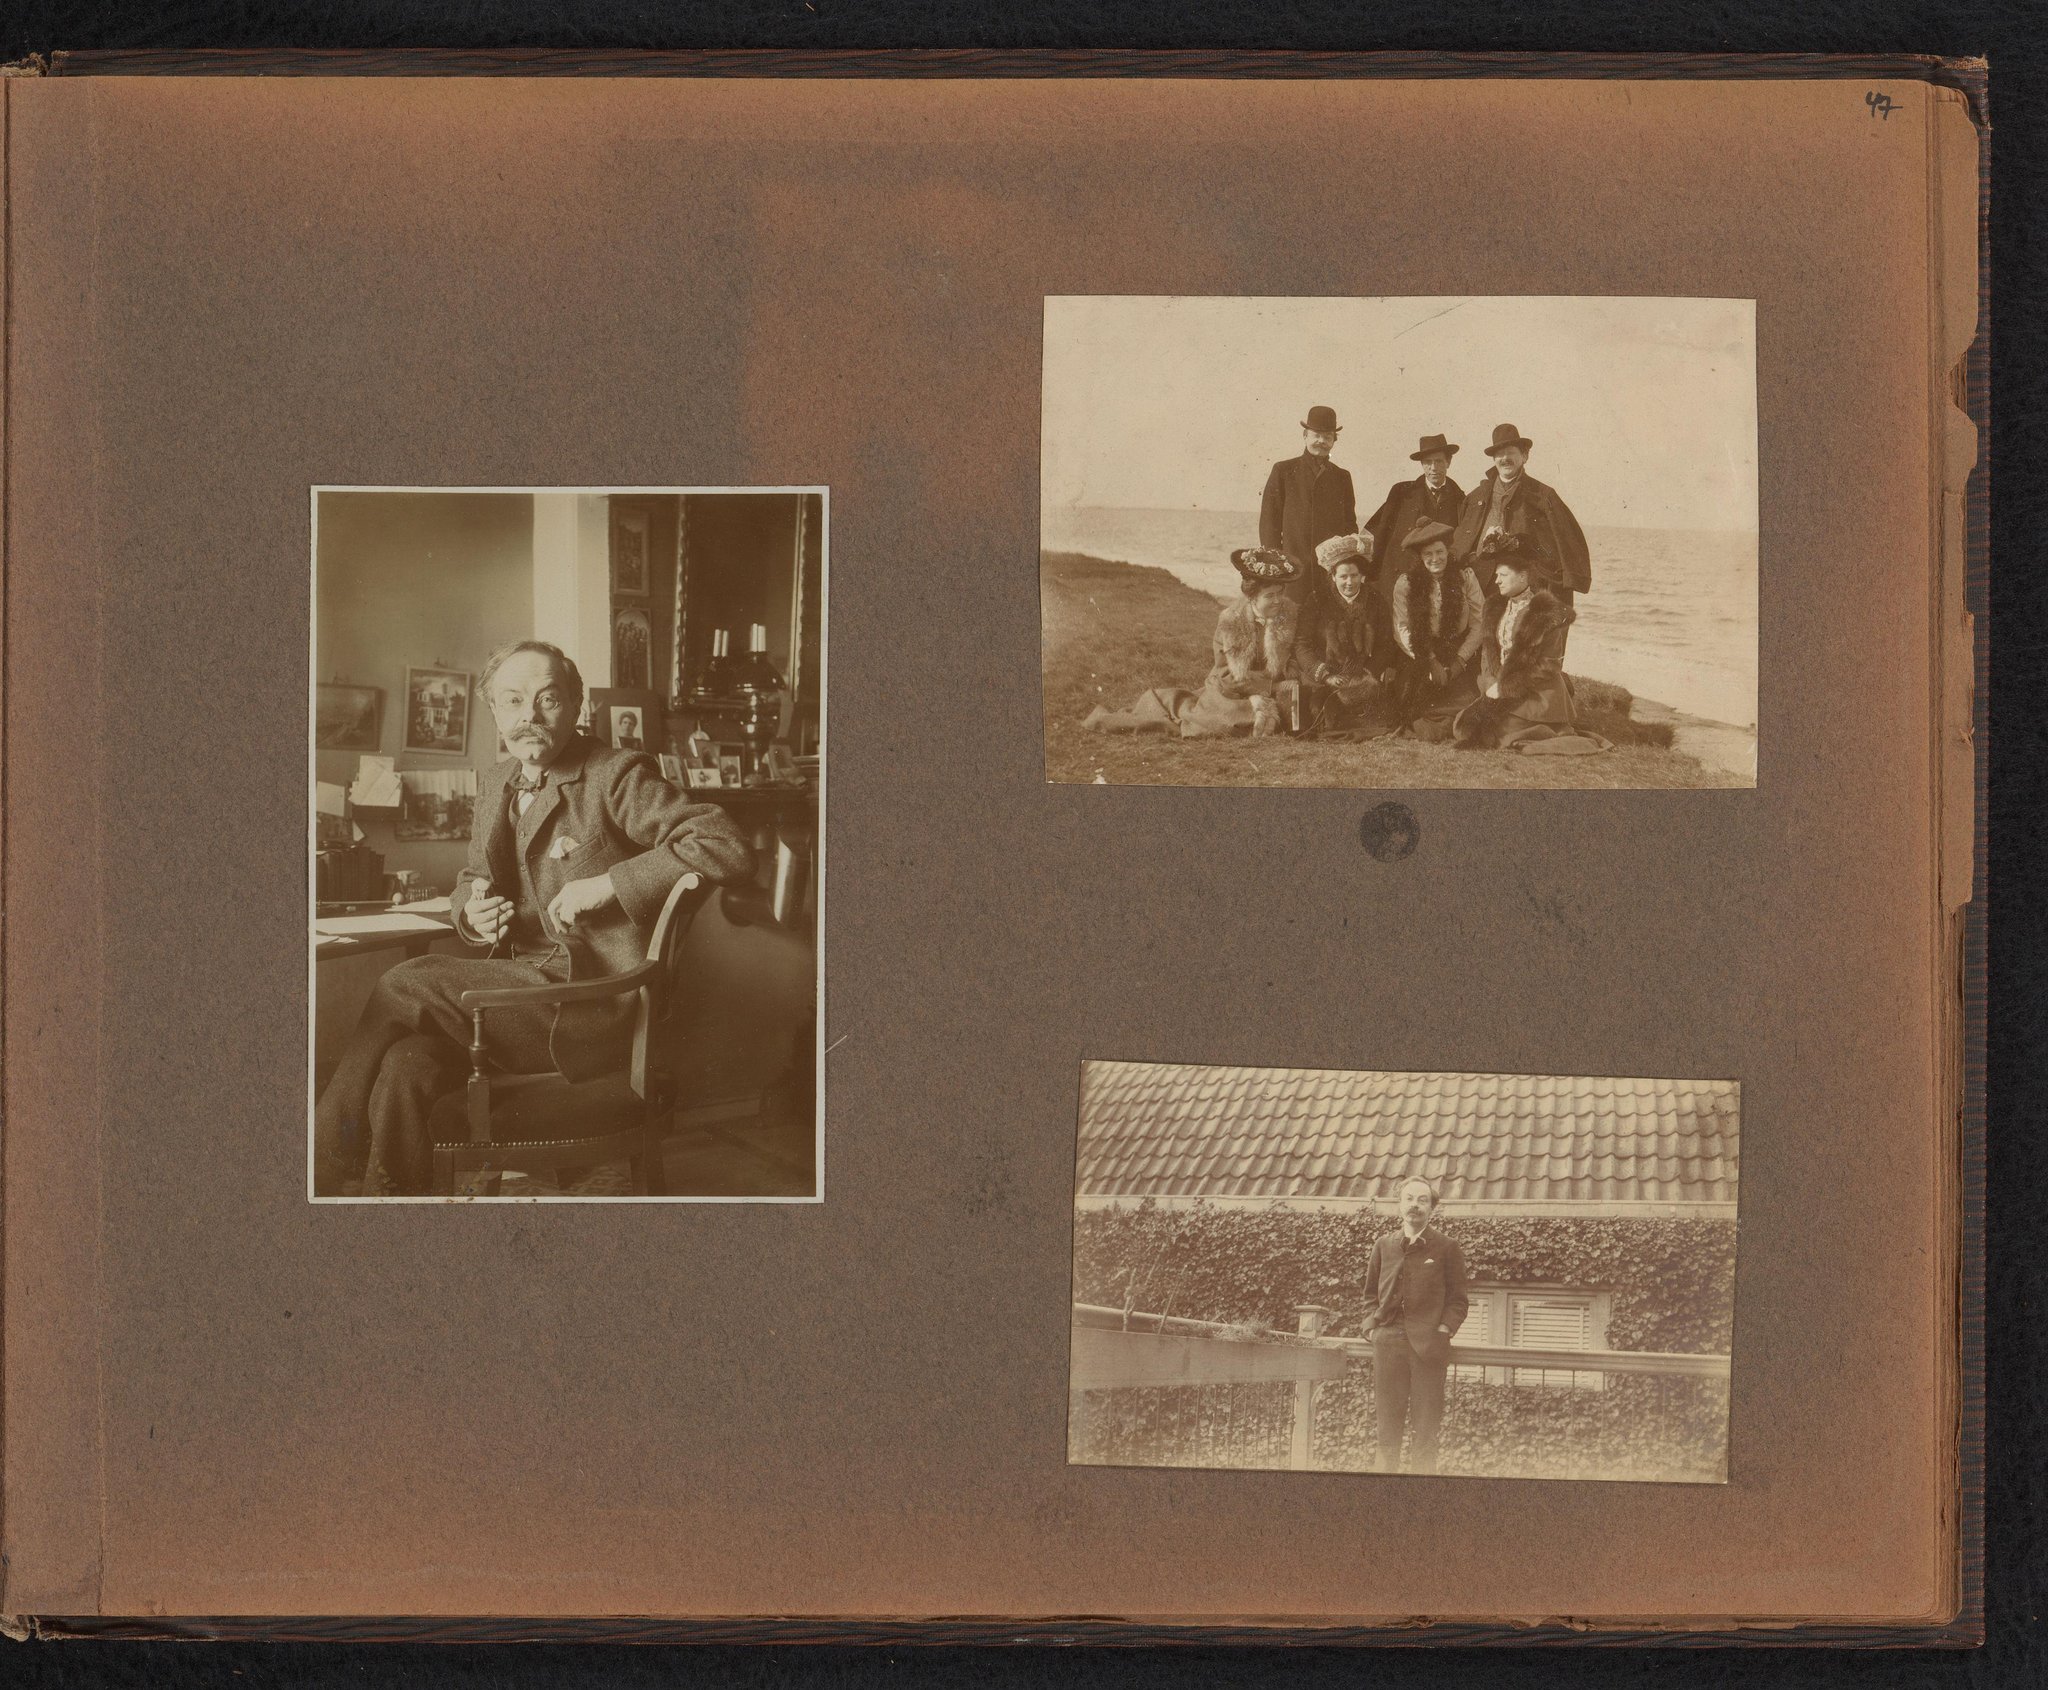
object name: photograph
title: Bladzijde uit het fotoalbum van de familie Diepenbrock met 3 foto's van Alphons Diepenbrock en zijn omgeving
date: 1909-1920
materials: cardboard, photographic support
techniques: photography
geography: netherlands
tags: amsterdam, alphons diepenbrock, netherlands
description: Bruin albumblad 47 van familiealbum van Alphons Diepenbrock.